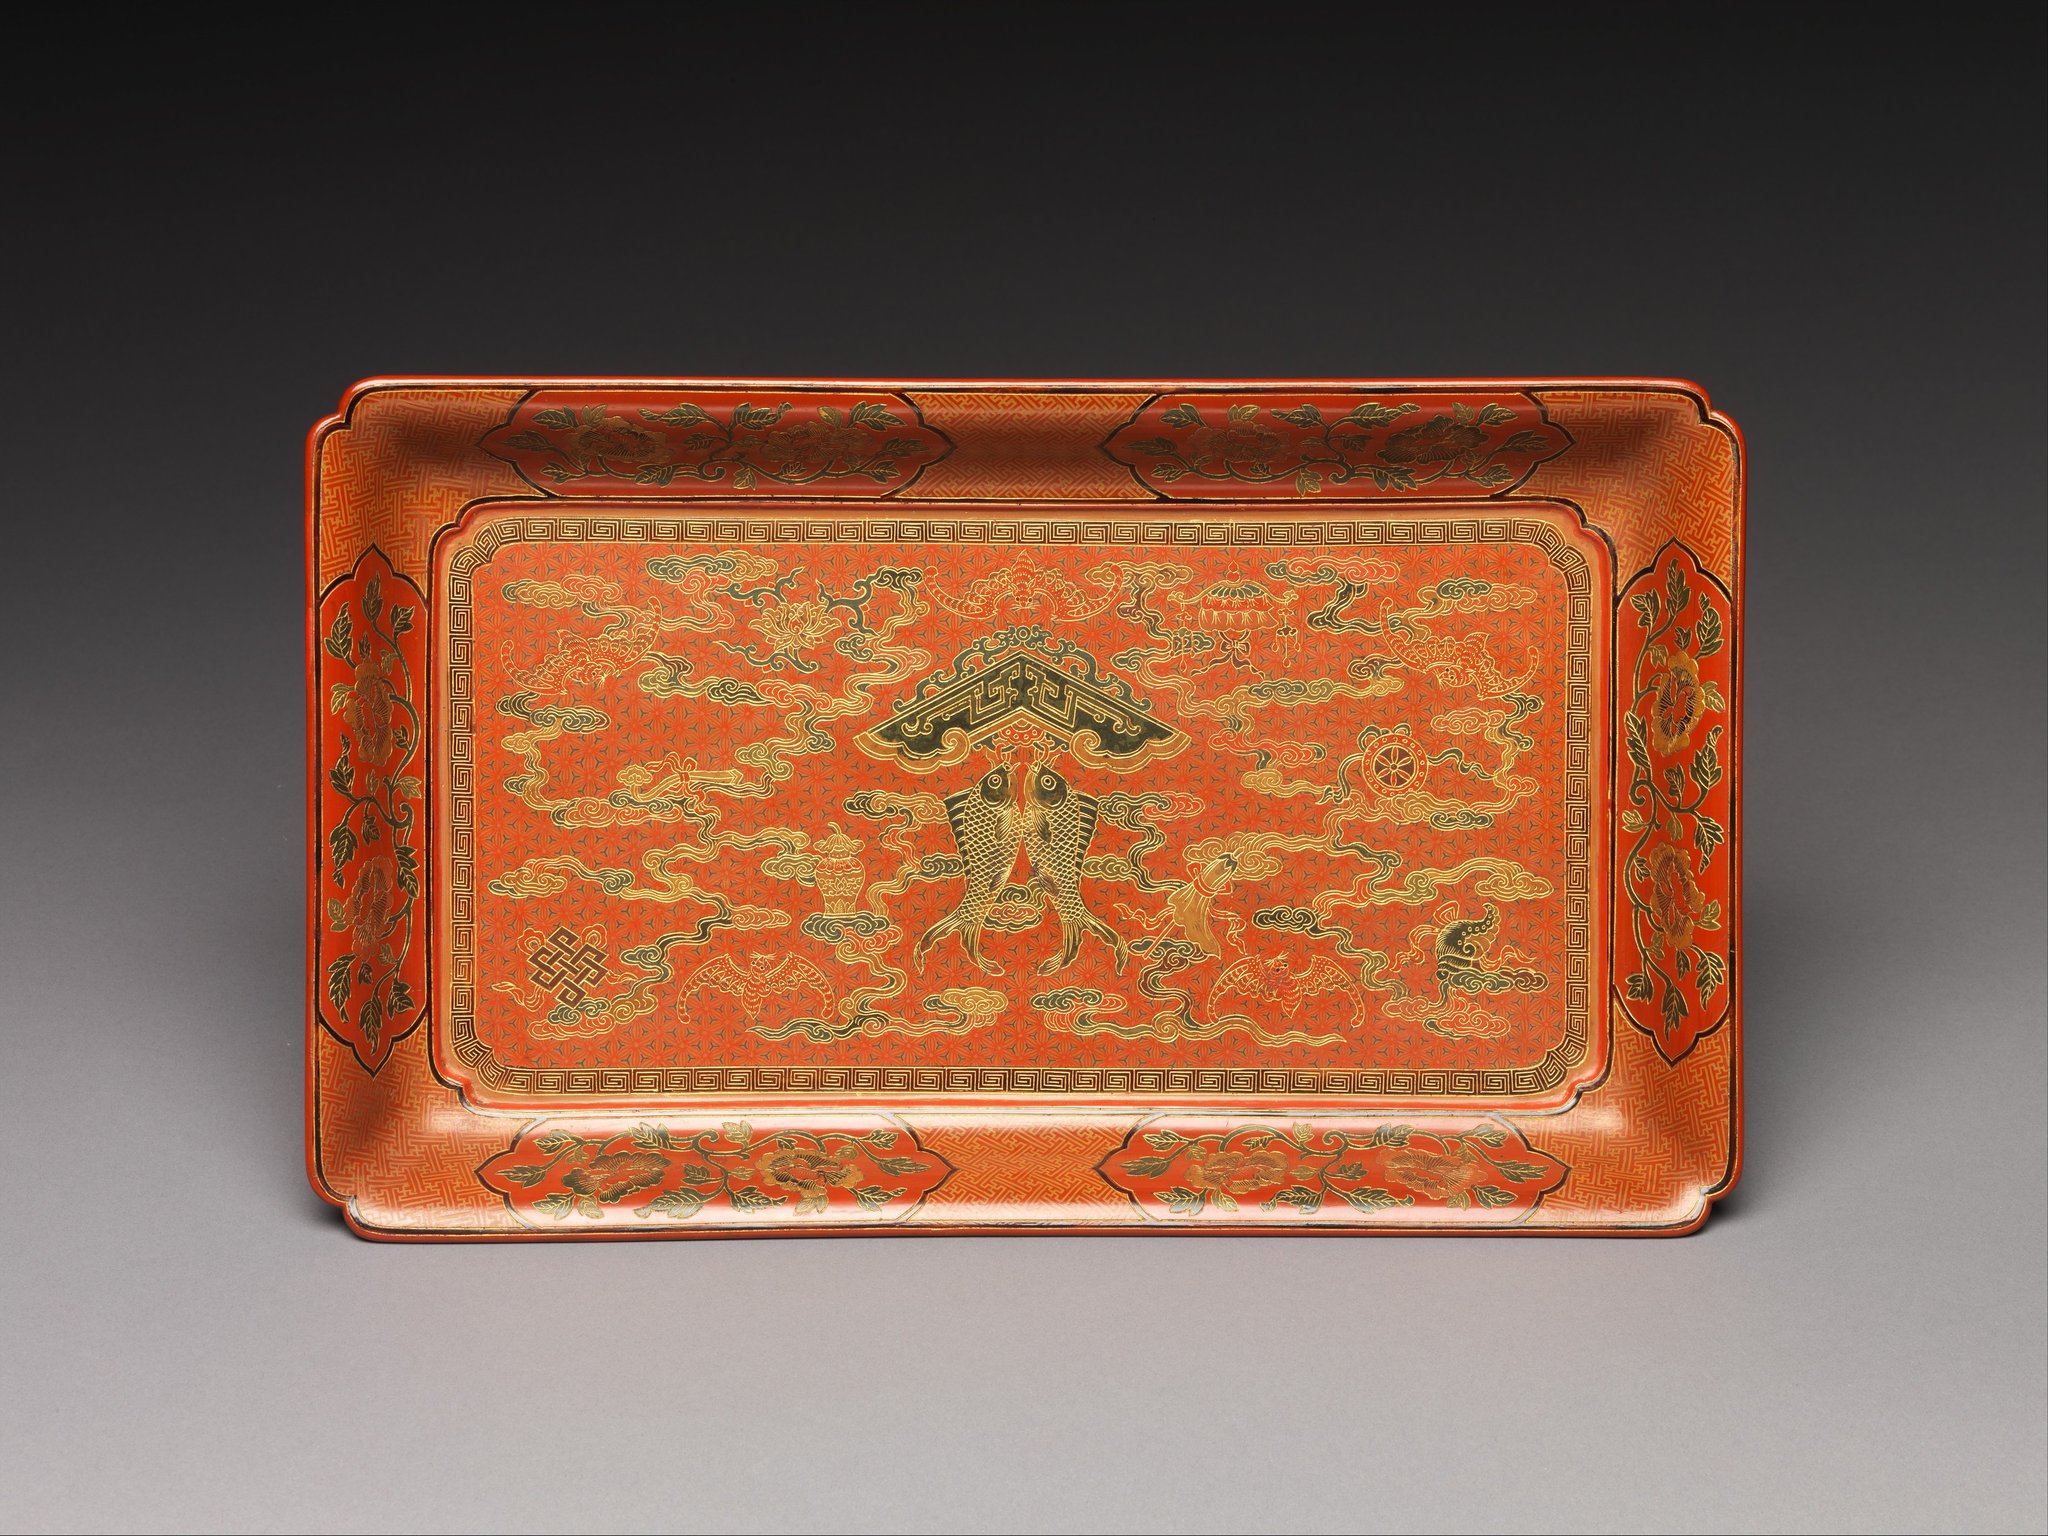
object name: tray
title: Rectangular tray with fish chime, treasures, and clouds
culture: chinese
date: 1736-1795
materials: gold, lacquer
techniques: engraving, polychrome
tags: fish